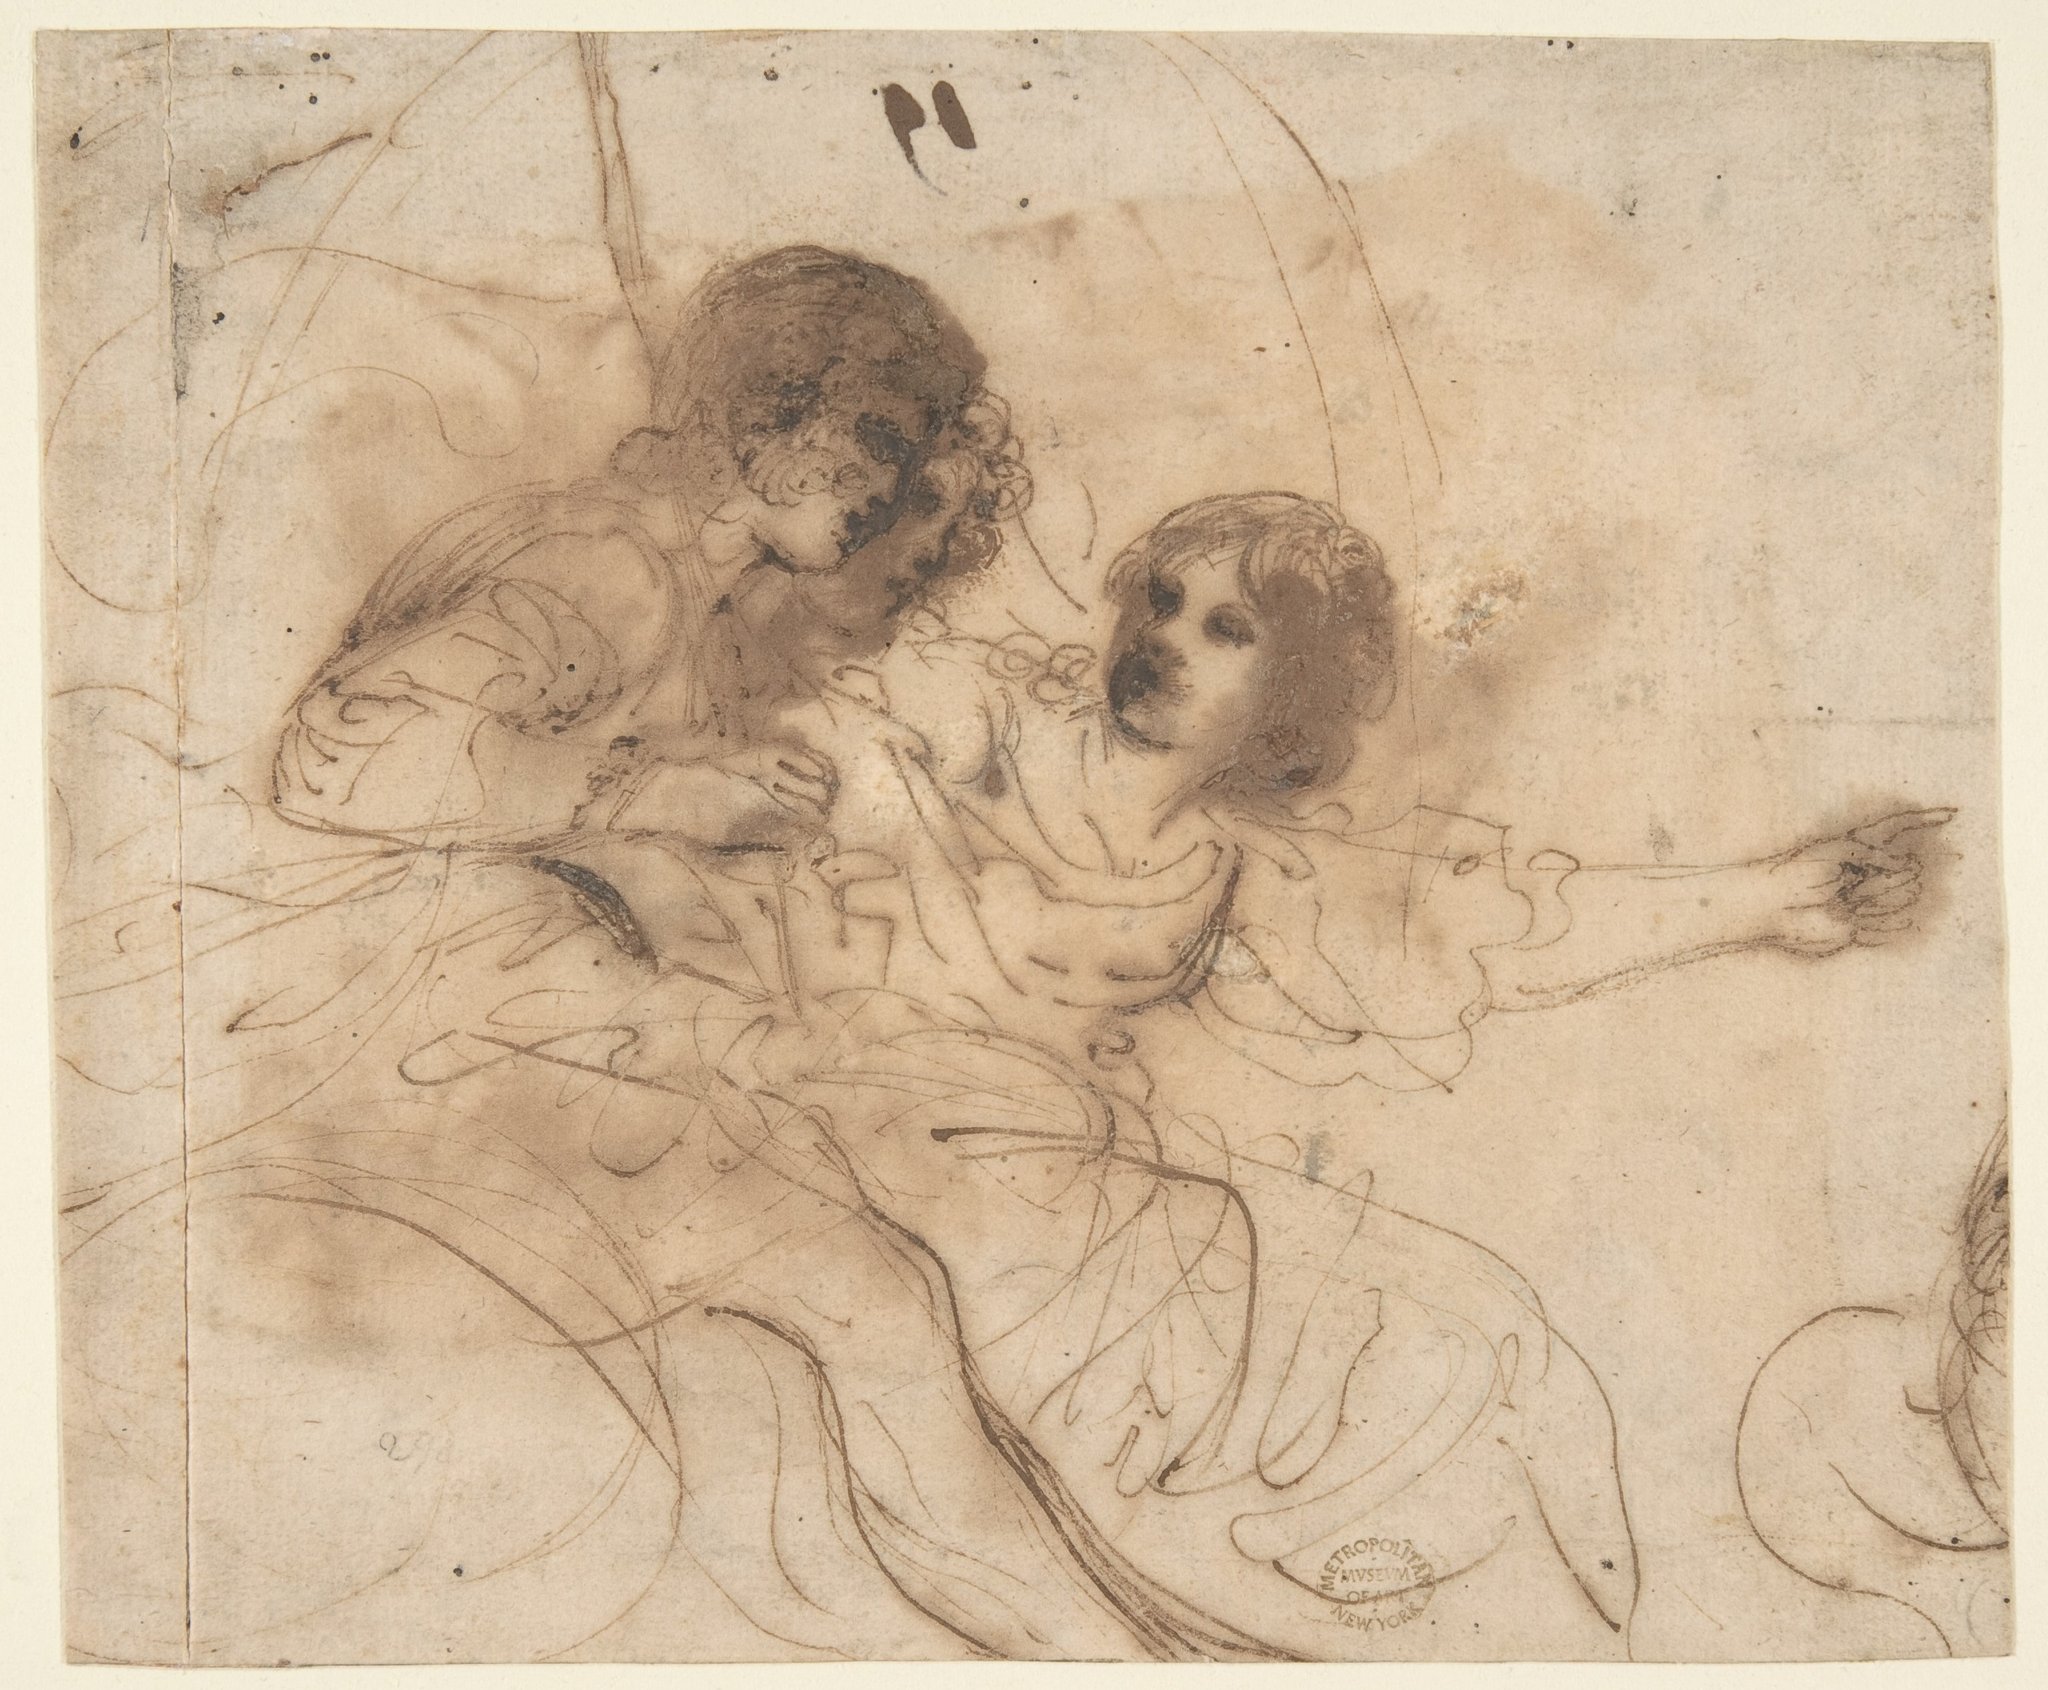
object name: drawing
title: Youth in a Chariot with Attendant Young Woman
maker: guercino (giovanni francesco barbieri)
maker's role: artist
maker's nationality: italian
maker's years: 1591-1666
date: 1621-1623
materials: ink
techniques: brush, pen, wash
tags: men,women,chariots